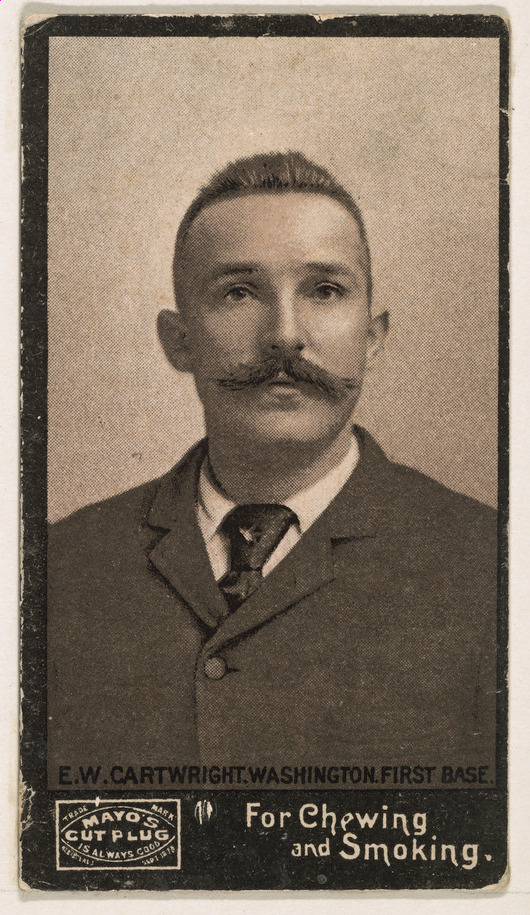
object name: print, baseball card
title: E. W. Cartwright, 1st Base, Washington, from Mayo's Cut Plug Baseball series (N300)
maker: p.h. mayo & brother, richmond, virginia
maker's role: publisher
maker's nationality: american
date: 1895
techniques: lithography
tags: men,portraits,baseball,athletes